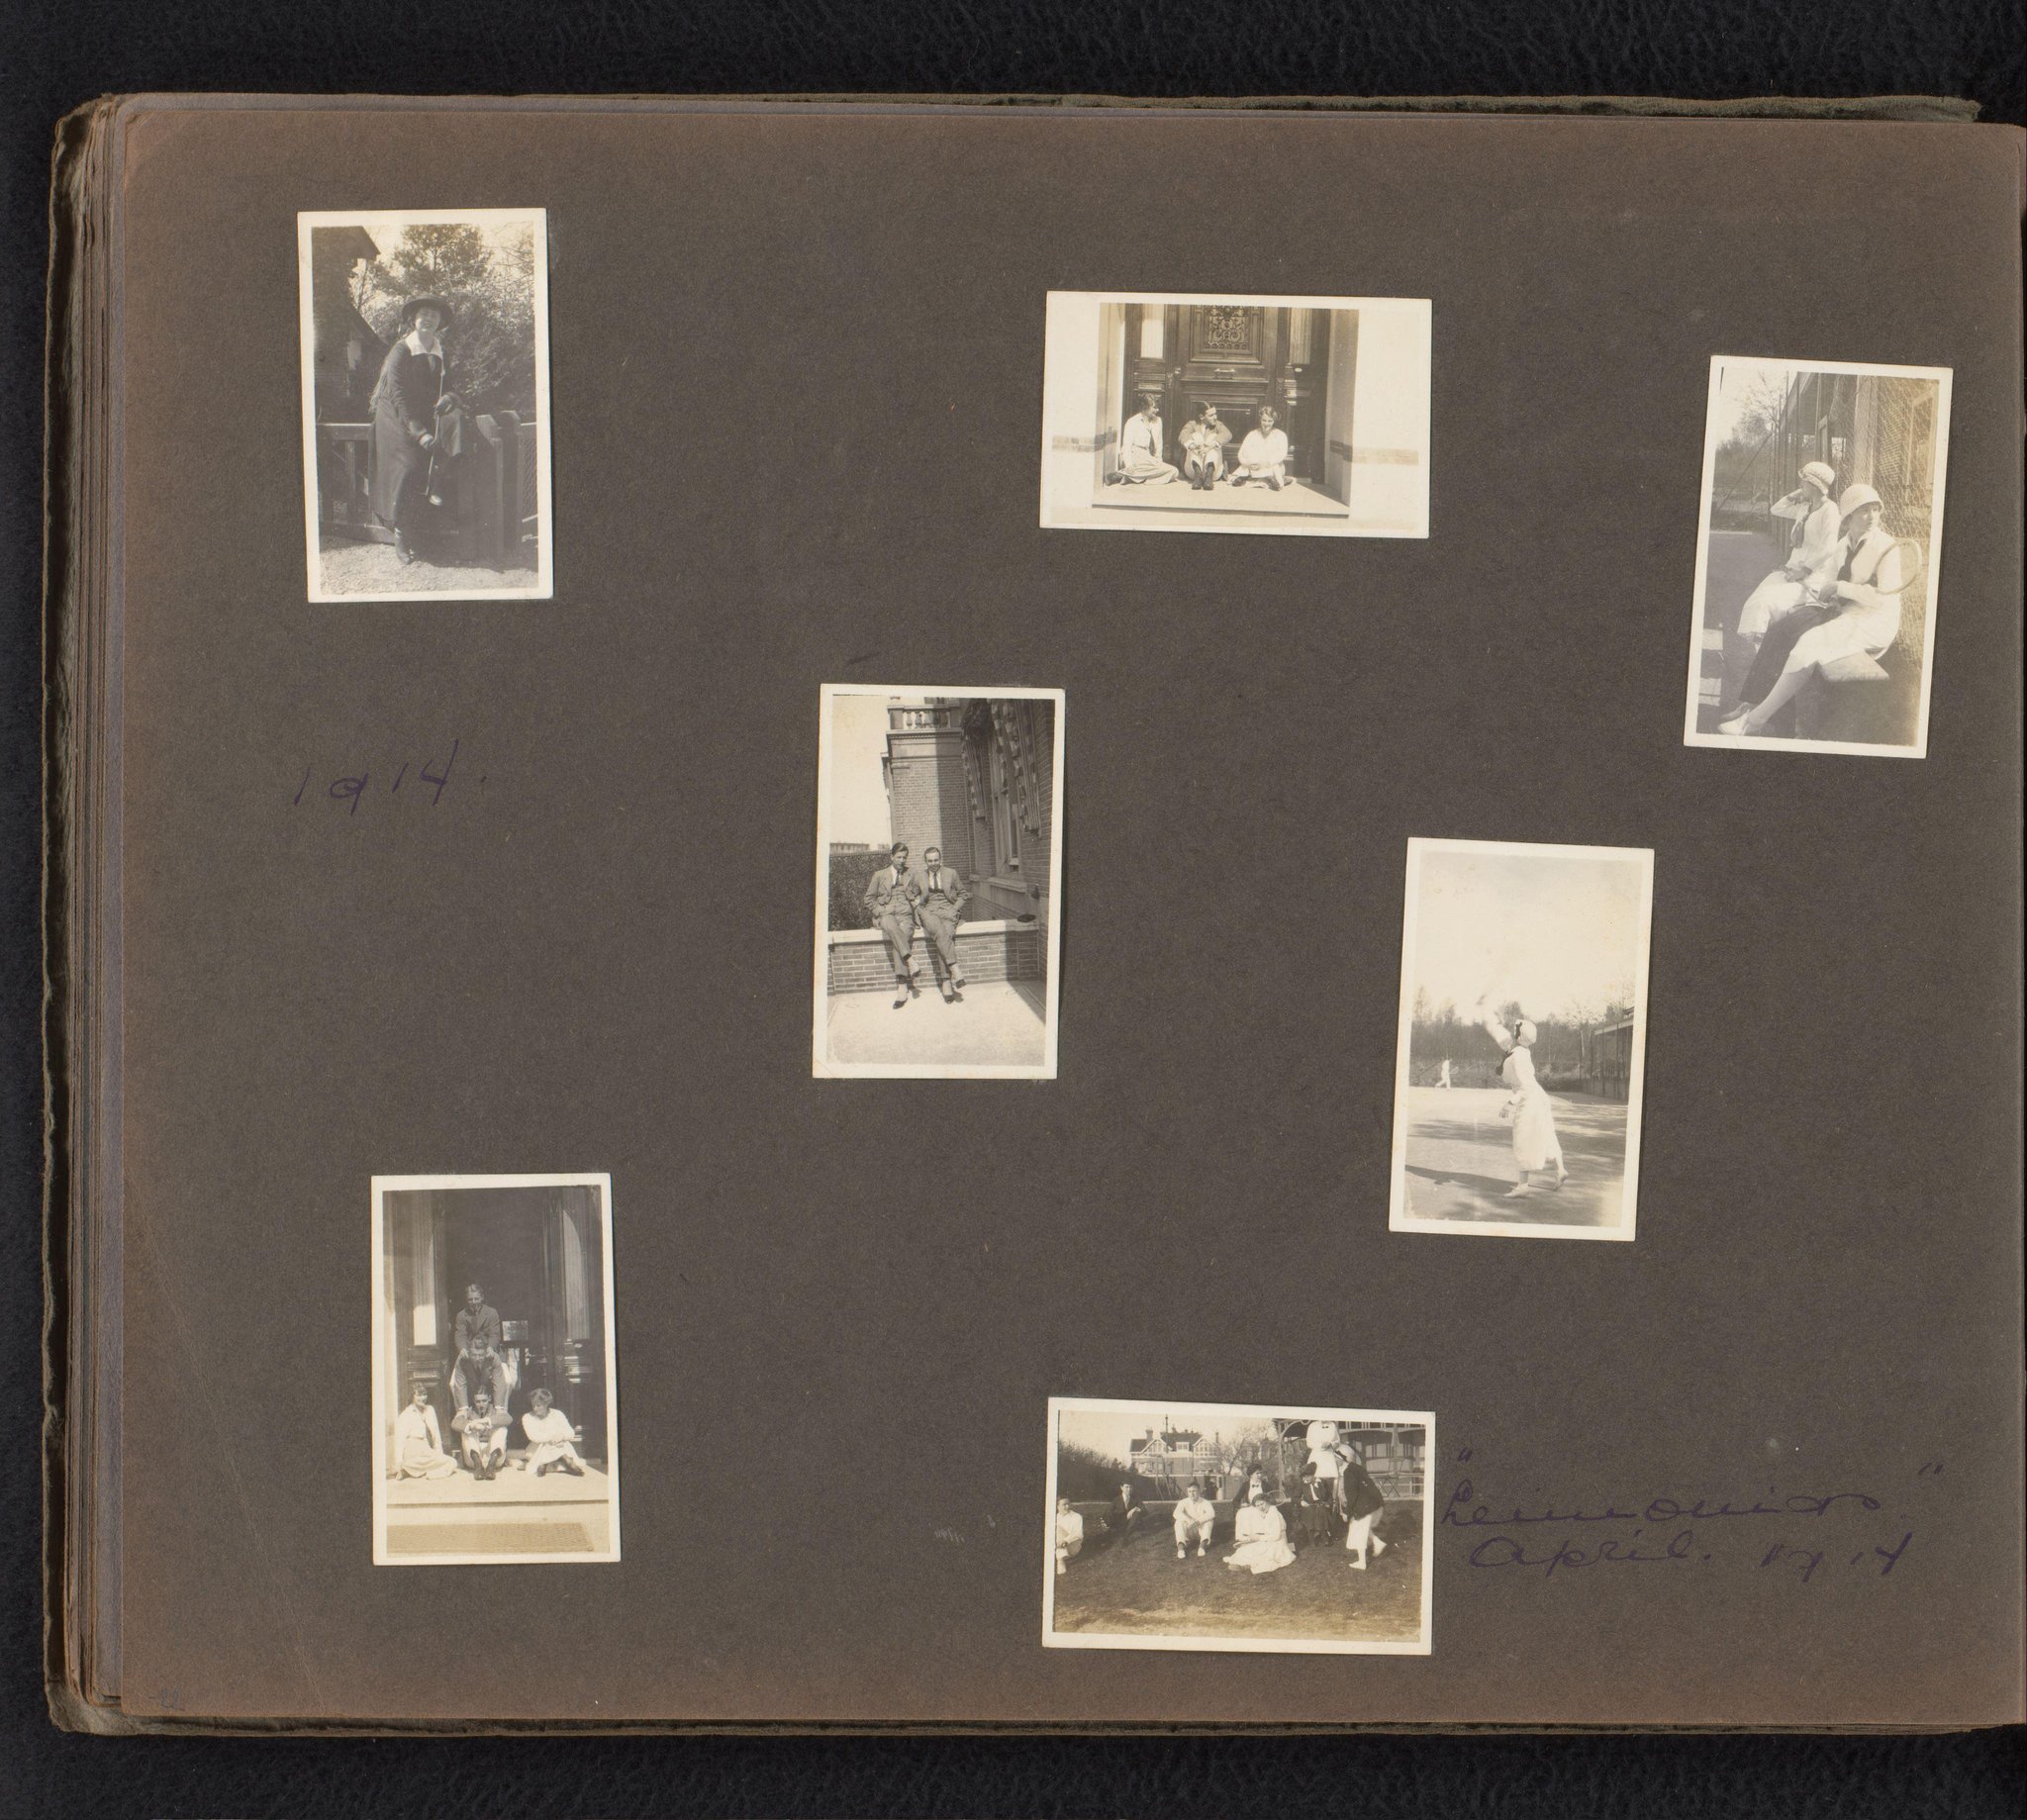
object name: album leaf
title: Vriendengroep bij Tennis Club Leimonias in Den Haag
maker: Anonymous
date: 1904-1914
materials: paper, cardboard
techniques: gelatin silver print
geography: the hague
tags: tennis, lawn-tennis, the hague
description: Deze foto's zijn onderdeel van een album.